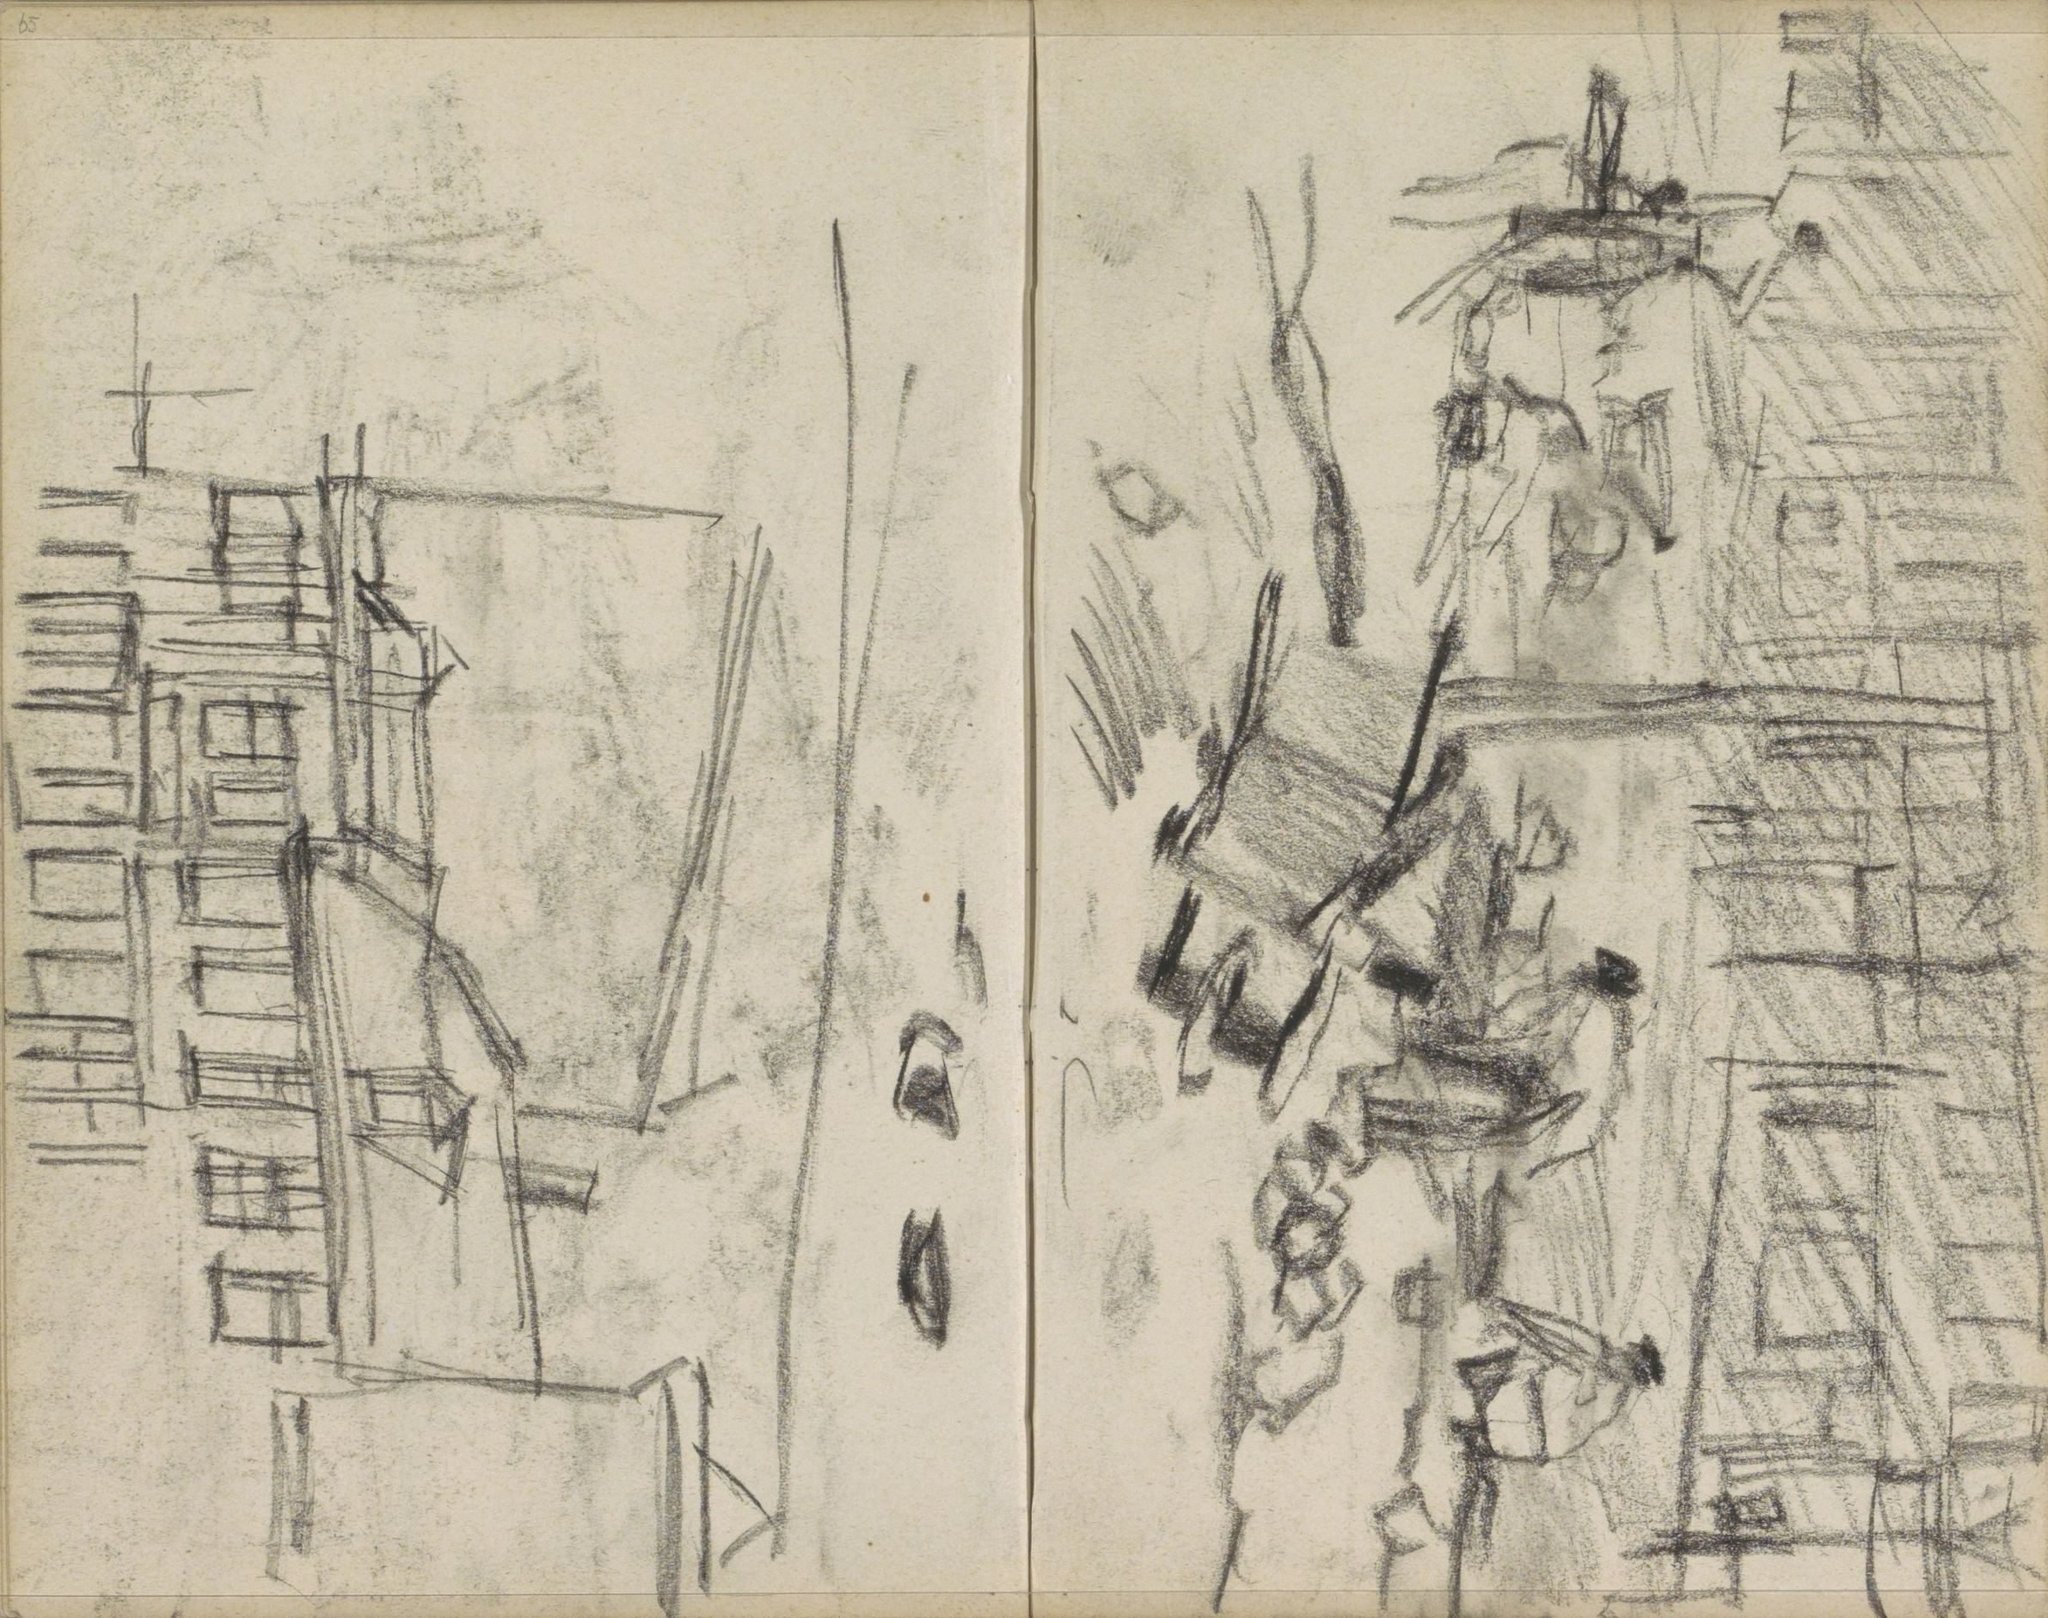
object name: sketchbook leaf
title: Stratenmakers en een gezicht in Amsterdam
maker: george hendrik breitner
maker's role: draughtsman, painter, print maker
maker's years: 1857-1923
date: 1886-1903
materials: chalk, paper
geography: amsterdam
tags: urban housing, working class, labourers, street, amsterdam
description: Pagina 65 en pagina 66 uit een schetsboek met 46 bladen.